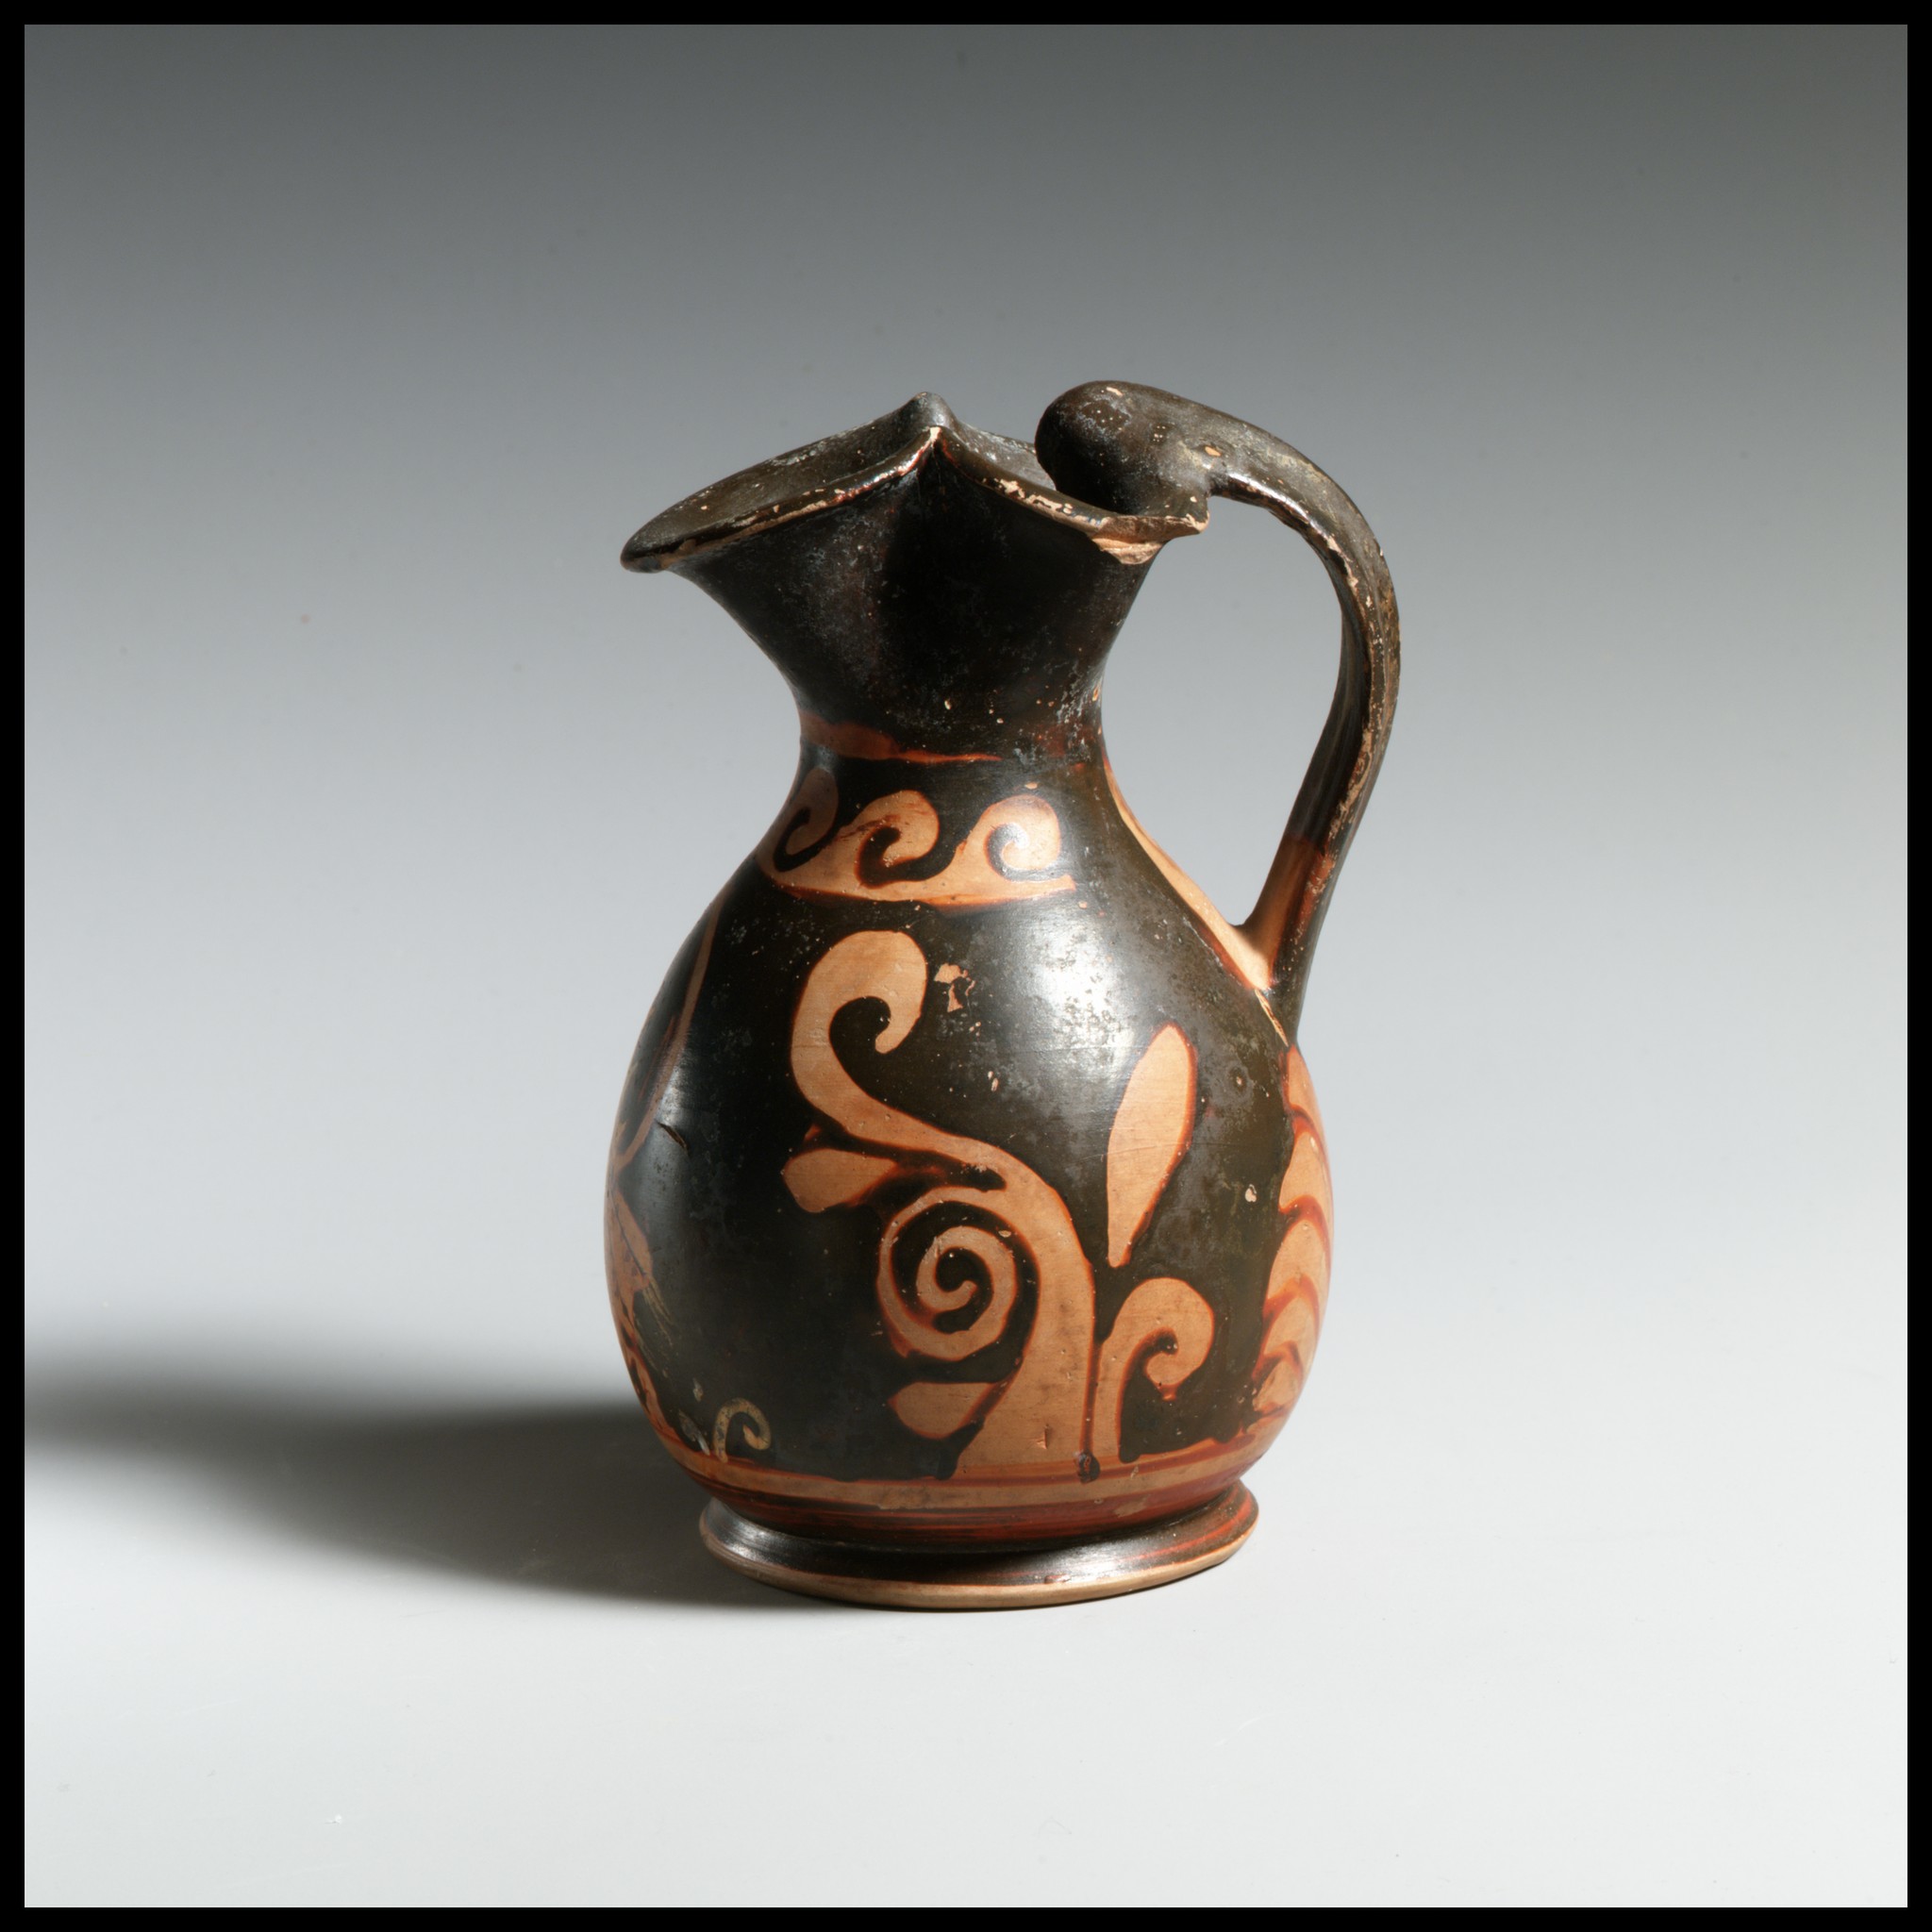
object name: oinochoe, chou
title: Terracotta oinochoe: chous (jug)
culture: greek, paestan or south italian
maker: heavy chin group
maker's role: artist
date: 350-325 BCE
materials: terracotta